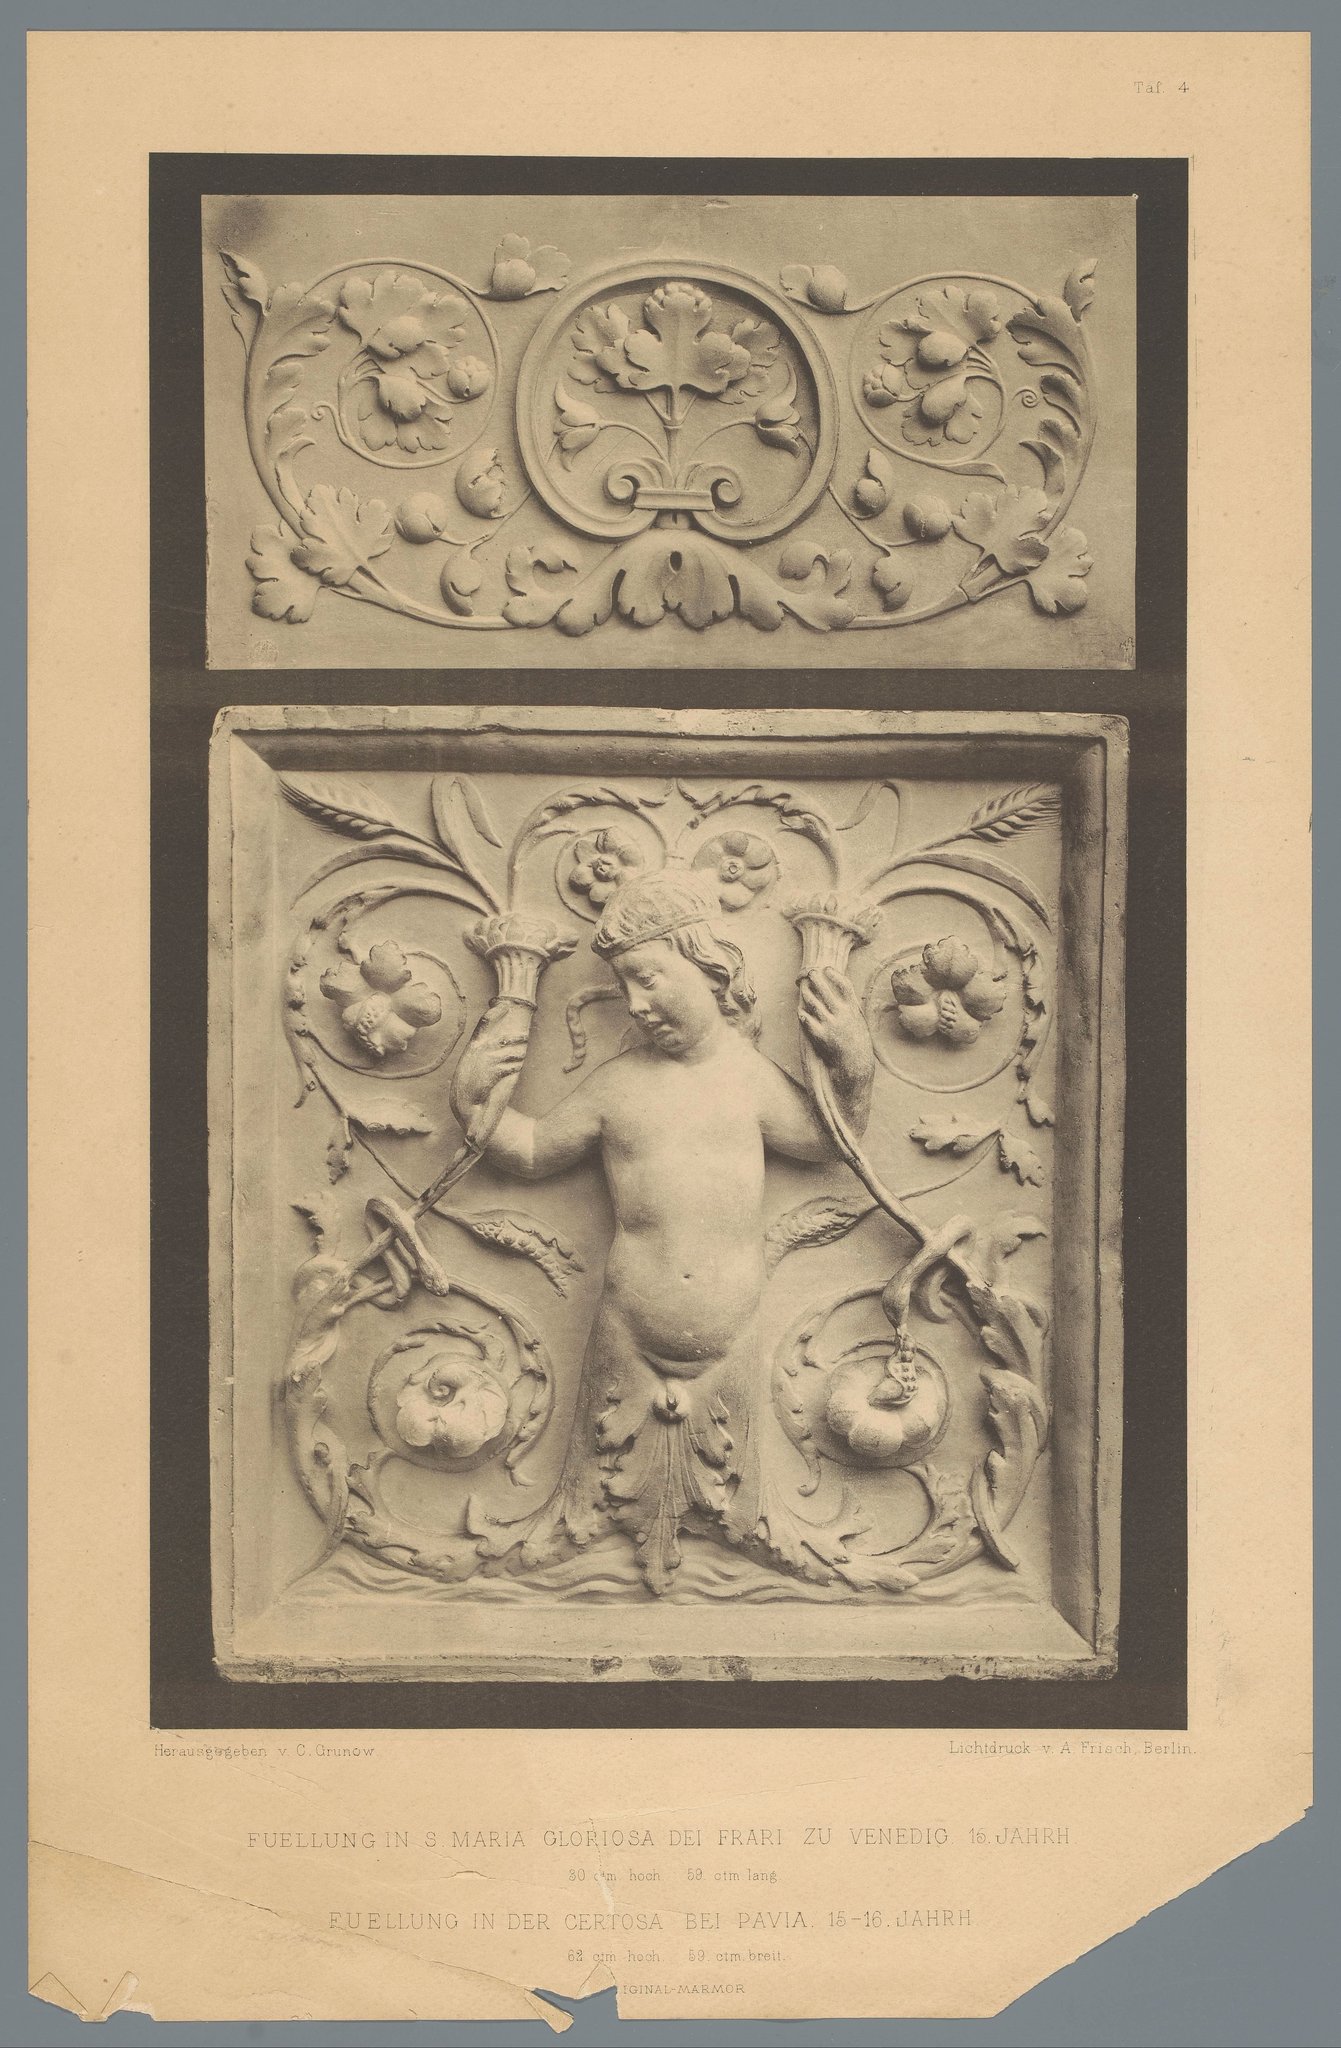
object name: photograph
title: FUELLUNG IN S. MARIA GLORIOSA DEI FRARI ZU VENEDIG. 15. JAHR. FUELLUNG IN DER CERTOSA BEI PAVIA. 15-16. JAHR.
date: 1875-1900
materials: paper, ink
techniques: photograph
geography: europe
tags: ear of corn, ornament derived from plant forms, sculpture (+ relief ~ sculpture)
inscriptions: number: ‘Taf. 4.’, inscription: ‘62 ctm hoch. 59 ctm. breit.’, inscription: ‘30 ctm hoch. 59 ctm lang’, inscription: ‘ORIGINAL-MARMOR’, collector's mark: Lugt 3937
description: Boven: reliëf met een bladmotief afkomstig uit de Basilica di Santa Maria Gloriosa dei Frari te Venetië, onder: reliëf met een jongen met korenaren afkomstig uit het kartuizerklooster te Pavia.